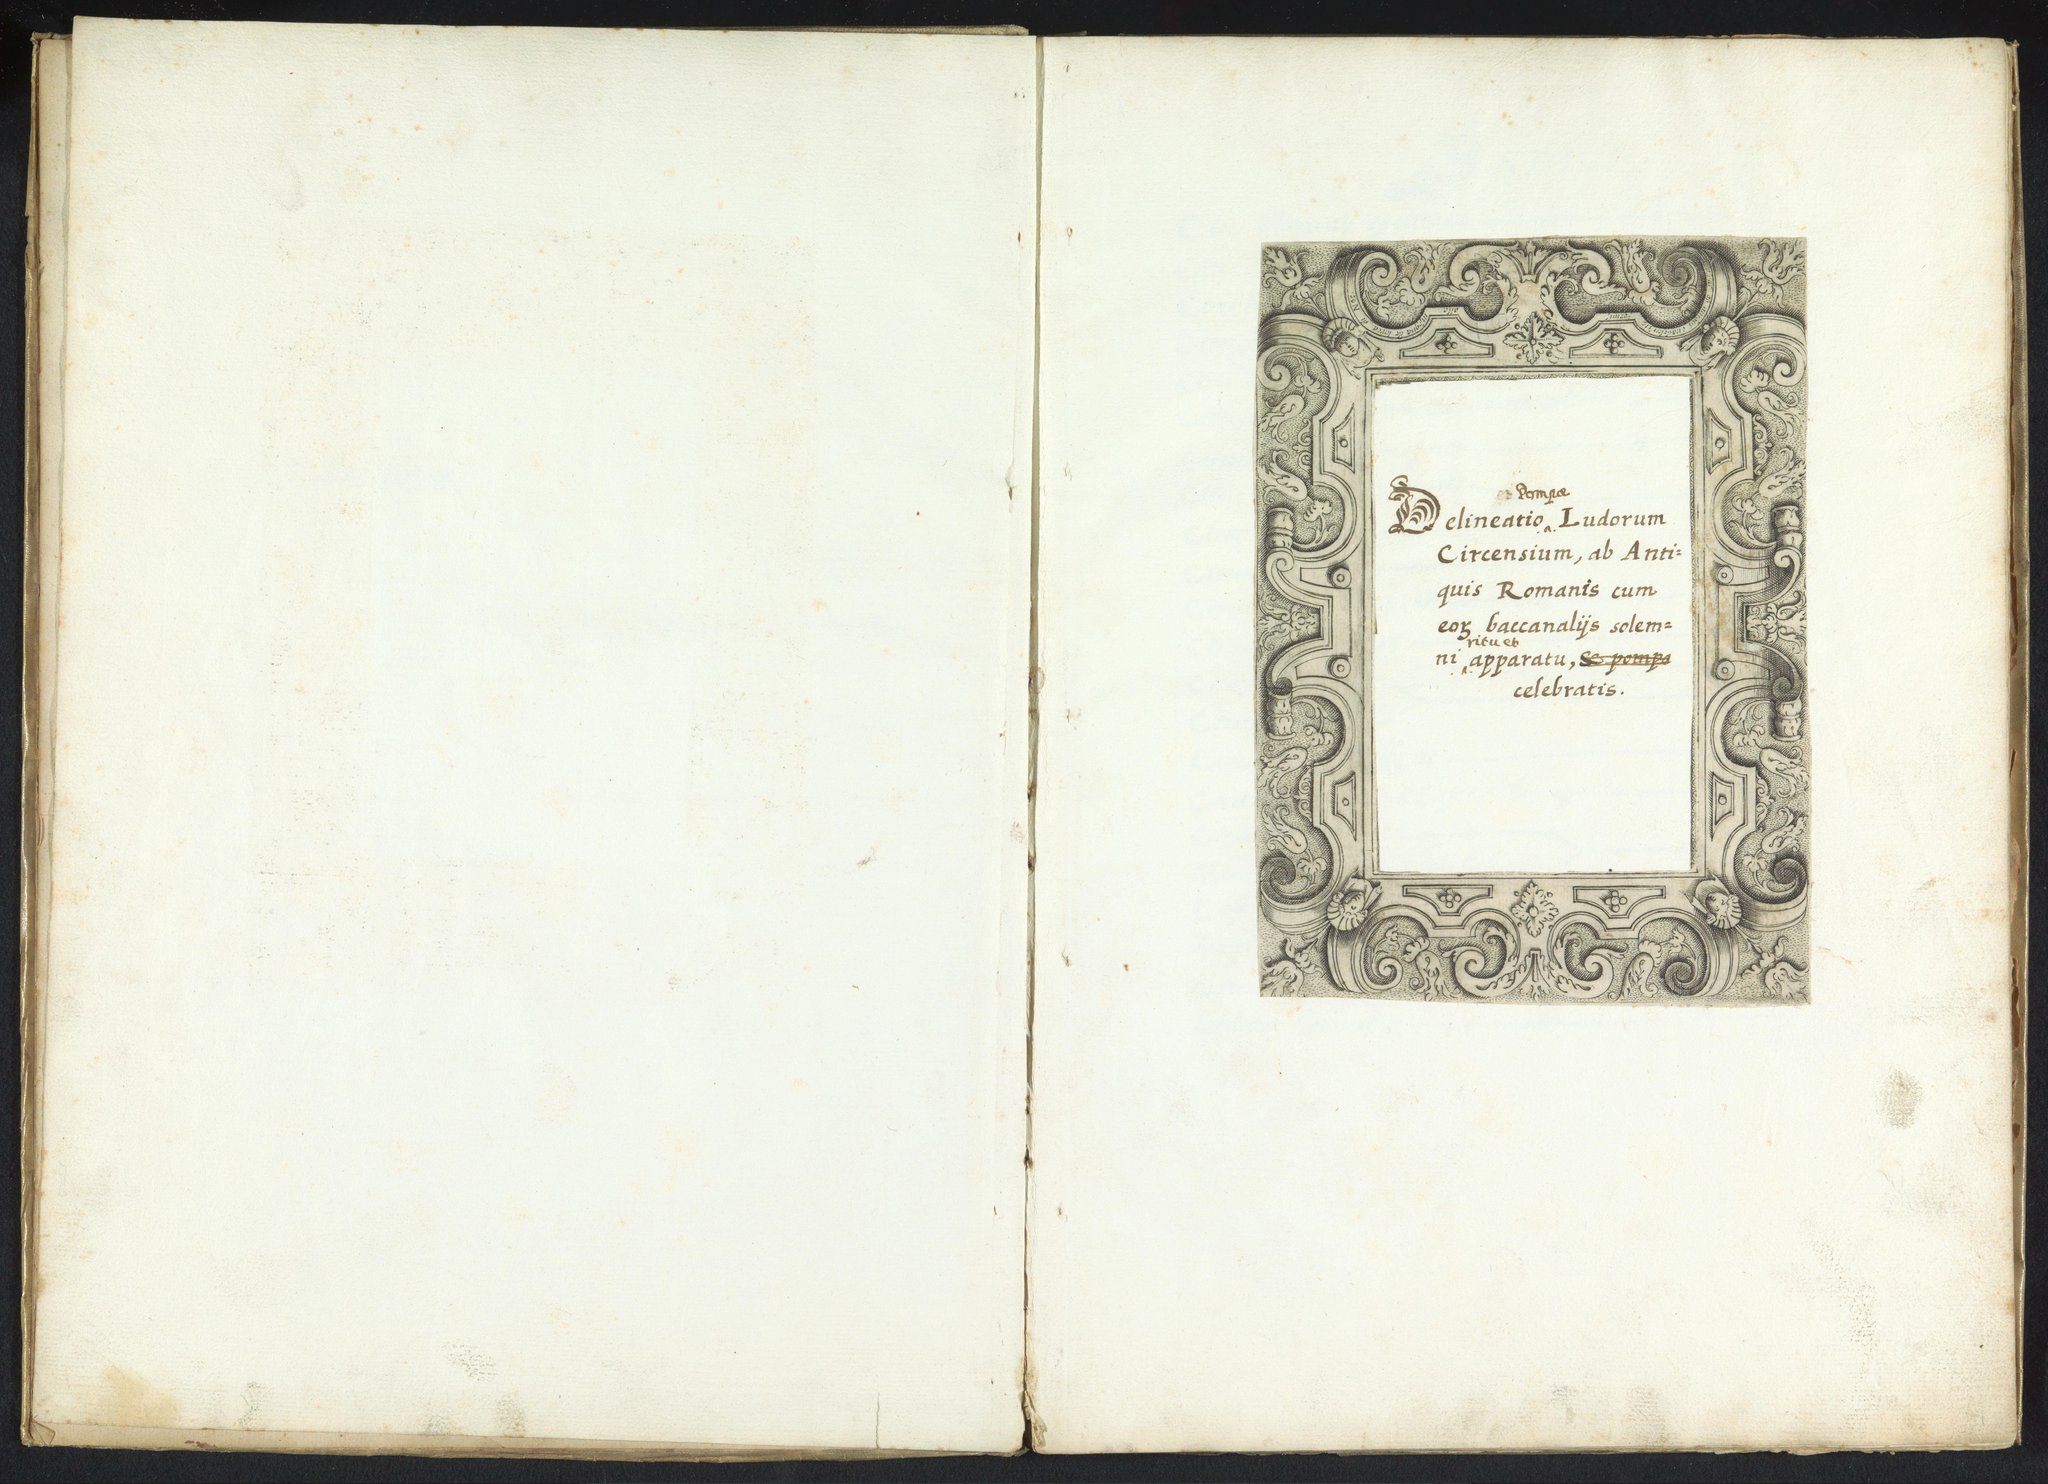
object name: print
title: Cartouche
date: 1546-1636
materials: paper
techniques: engraving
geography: italy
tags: ornament ~ cartouche, ornament derived from plant forms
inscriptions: inscription: ‘Delineatio Pompae Ludorum Circensium, ab Antiquis Romanis cum eor baccanaliis solemni ritu et apparatu, celebratis.’